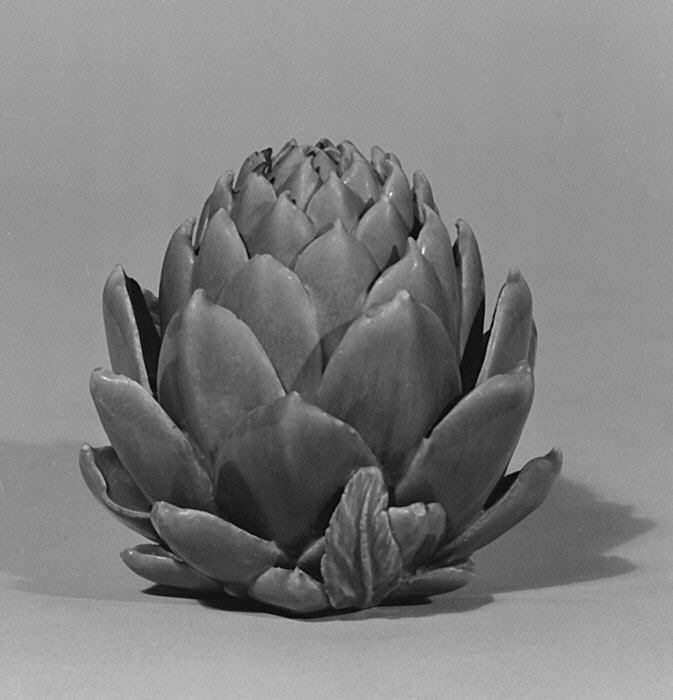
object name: box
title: Artichoke forming a box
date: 1750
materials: earthenware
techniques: glazing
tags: flowers